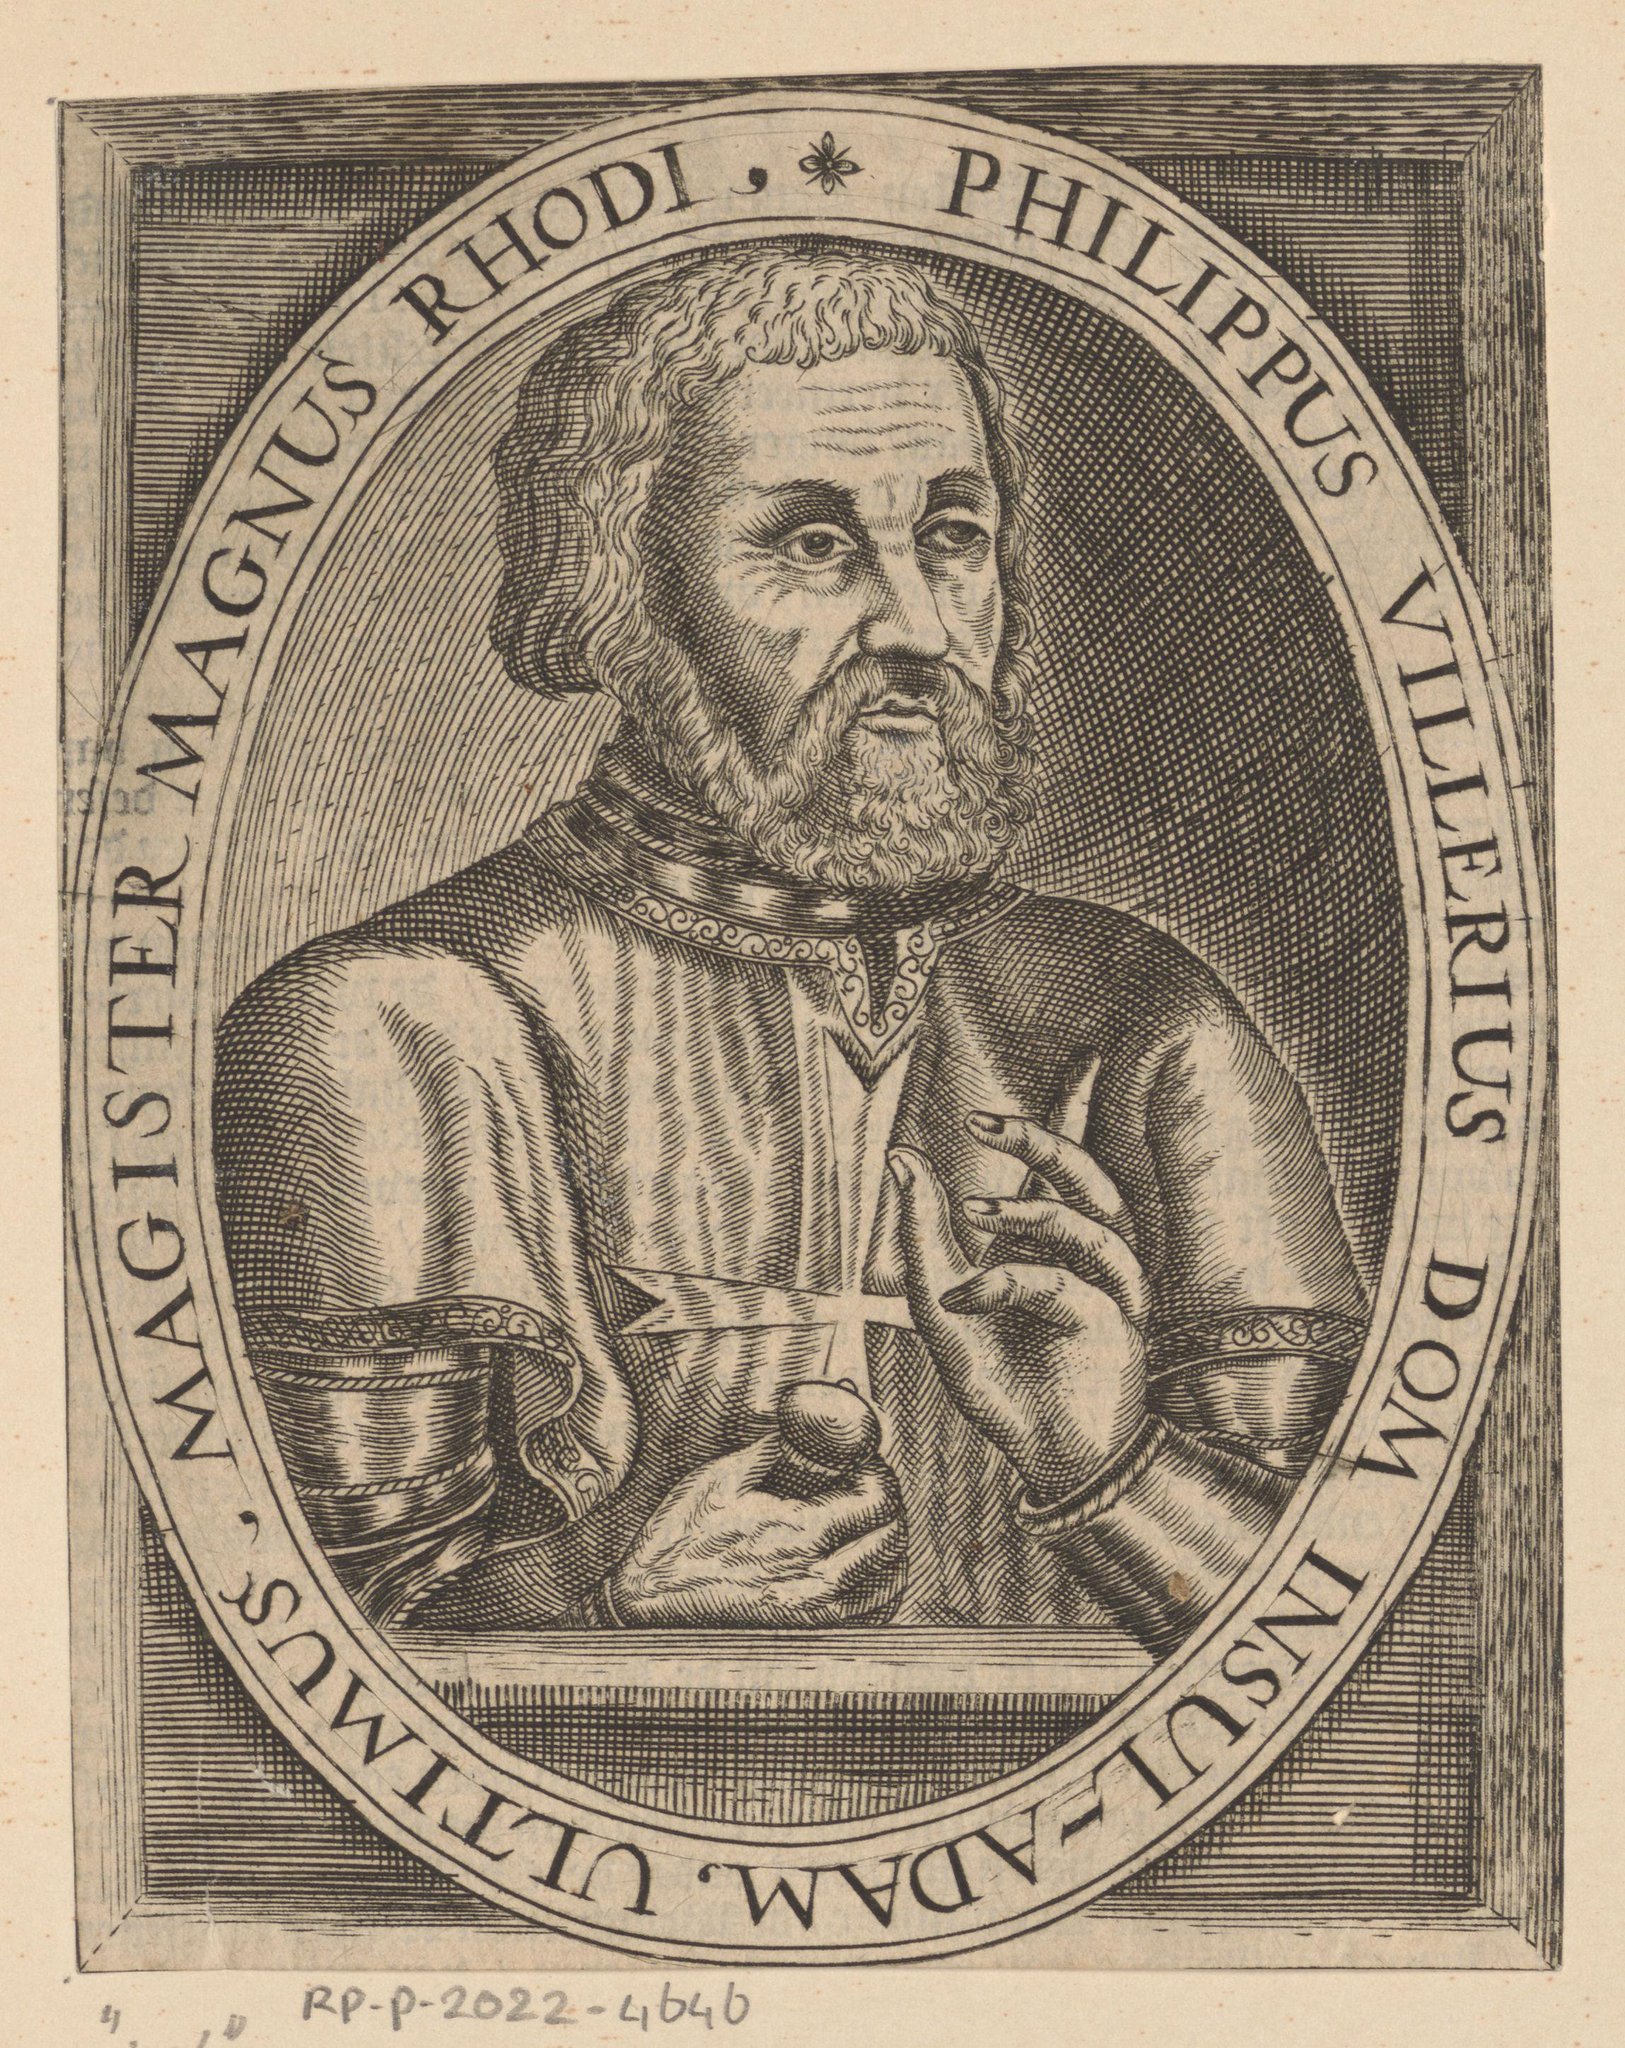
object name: book illustration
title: Portret van Philippe Villiers de l'Isle Adam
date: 1617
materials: paper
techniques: engraving, letterpress printing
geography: northern netherlands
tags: armour, historical persons, military orders, e.g.: knights templars, knights of malta, teutonic knights ~ roman catholic church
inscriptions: collector's mark: Lugt 2228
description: Prent uit: Tooneel der beroemder hertogen princen graven ende krygs-helden van Christenrijck binnen dese drij laeste eeuwen (...). Delft: Nicolaes de Clerck, 1617, p. 351.